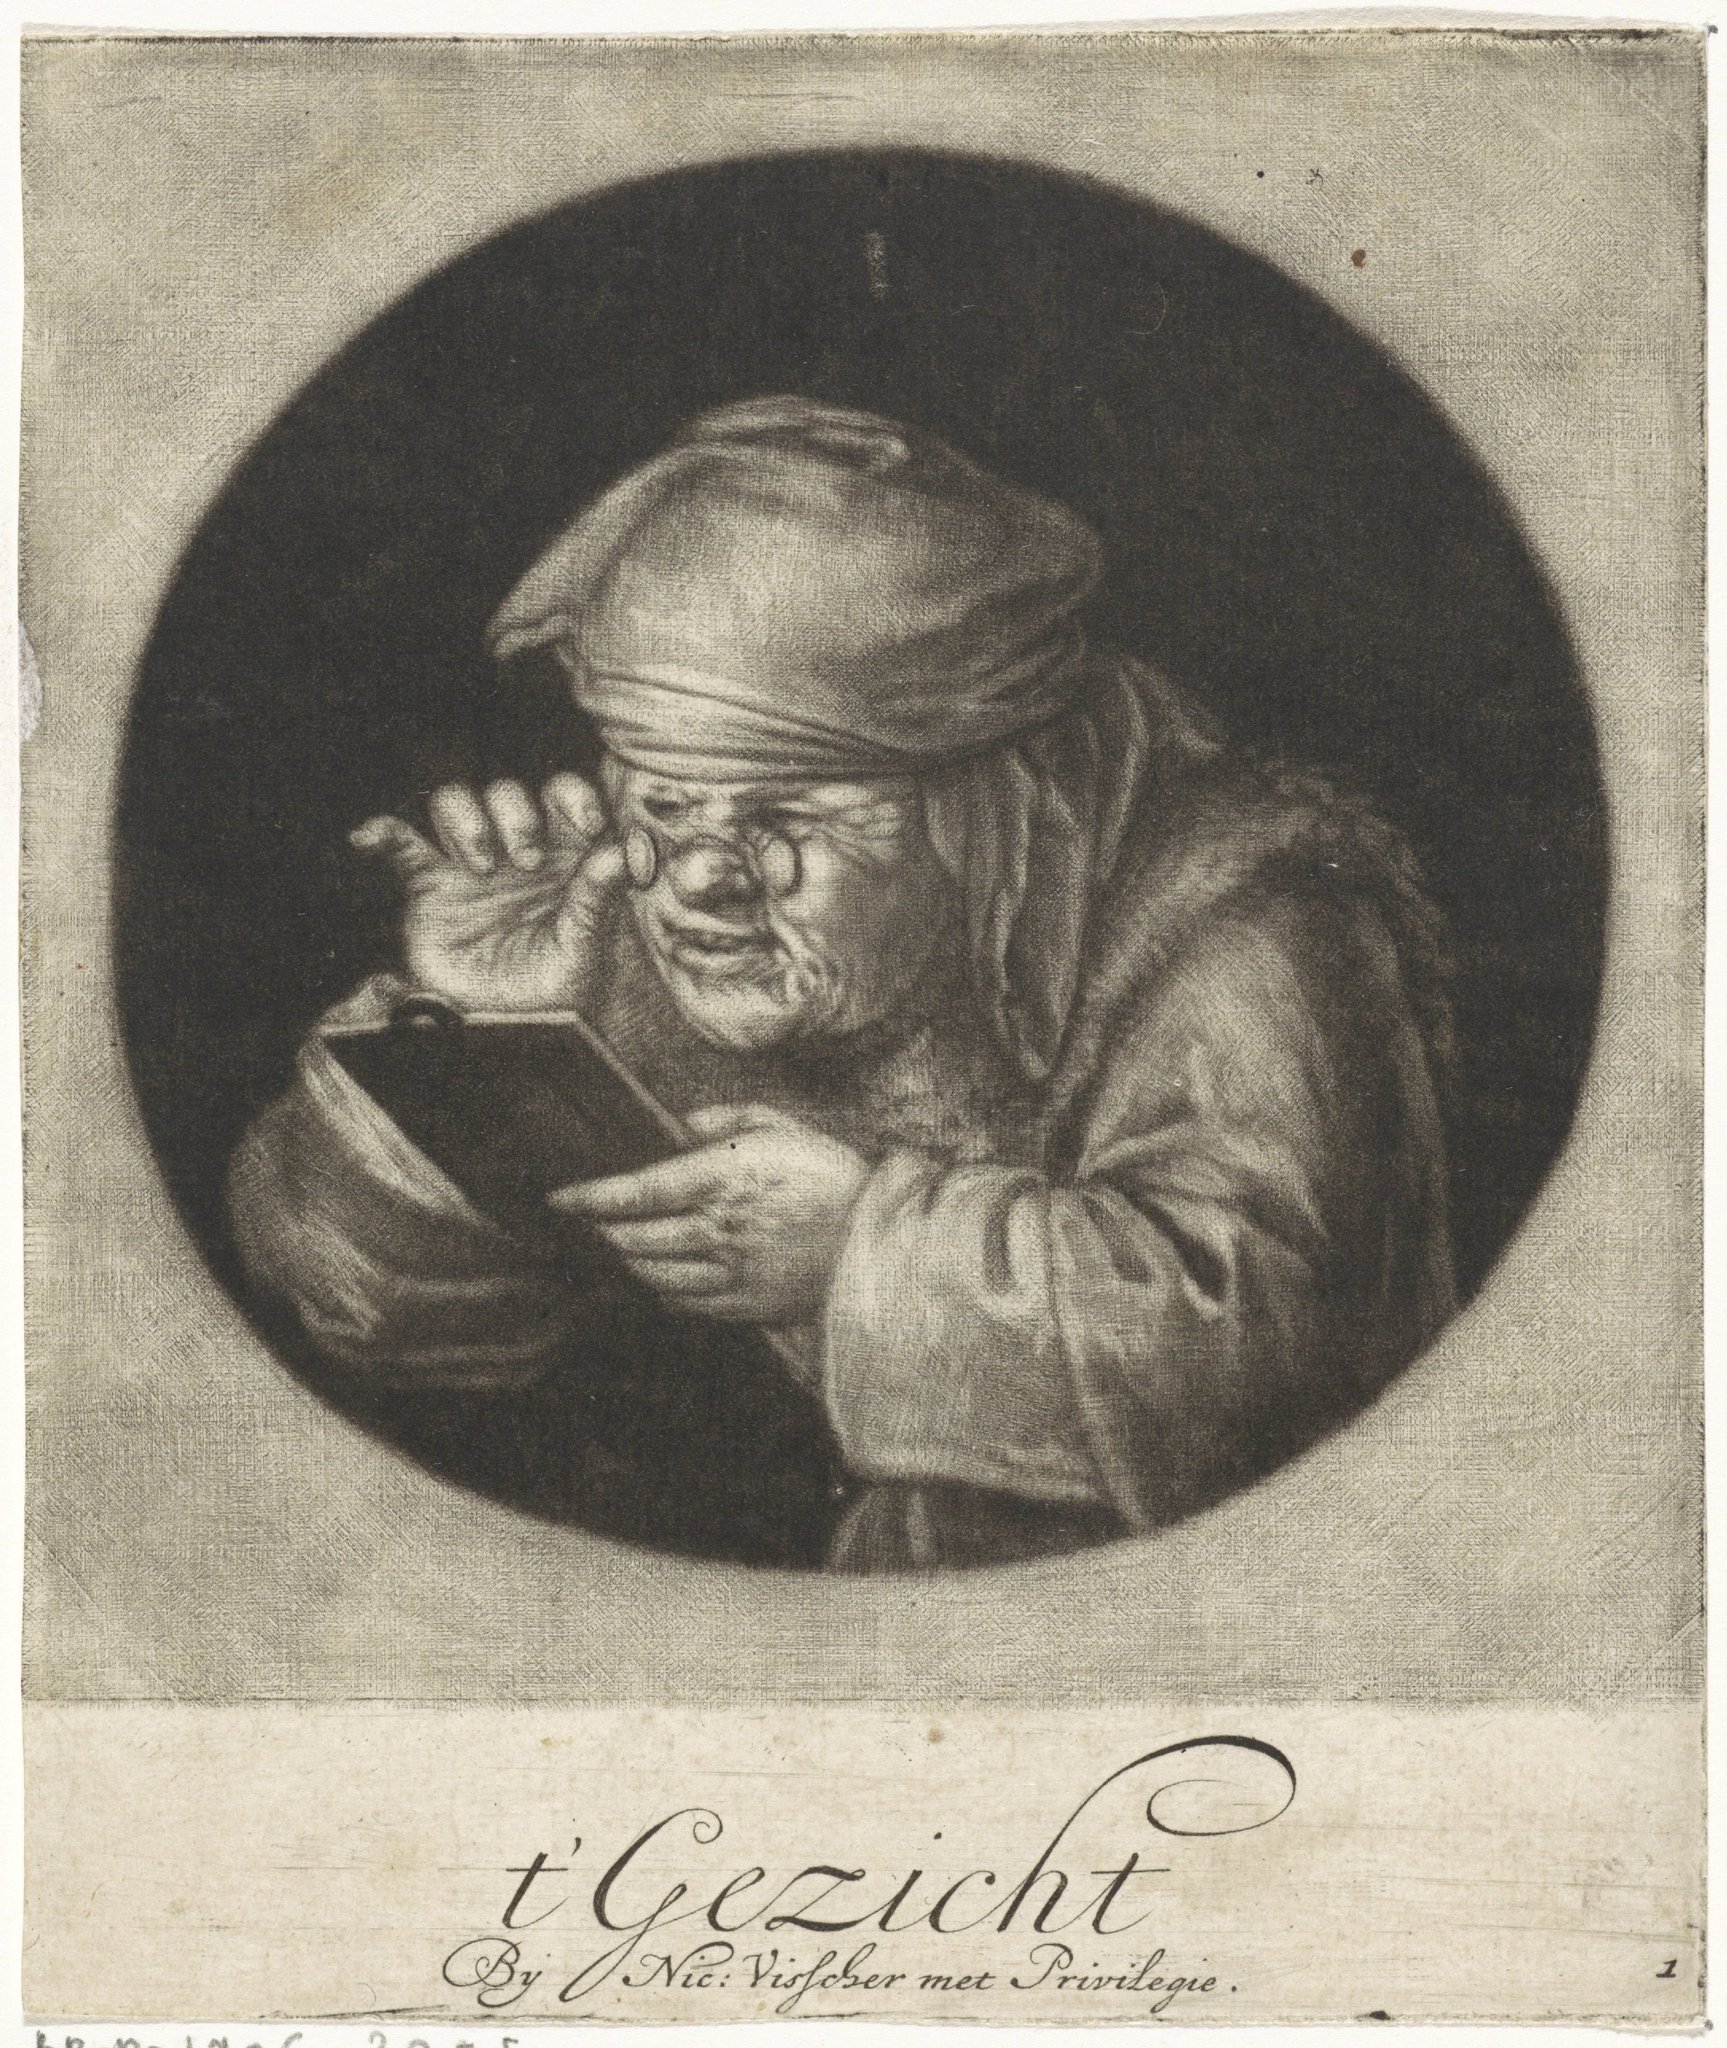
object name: print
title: Het Gezicht: lezende oude vrouw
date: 1670-1709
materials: paper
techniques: engraving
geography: amsterdam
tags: reading, sight, looking (one of the five senses)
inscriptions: collector's mark: Lugt 2228